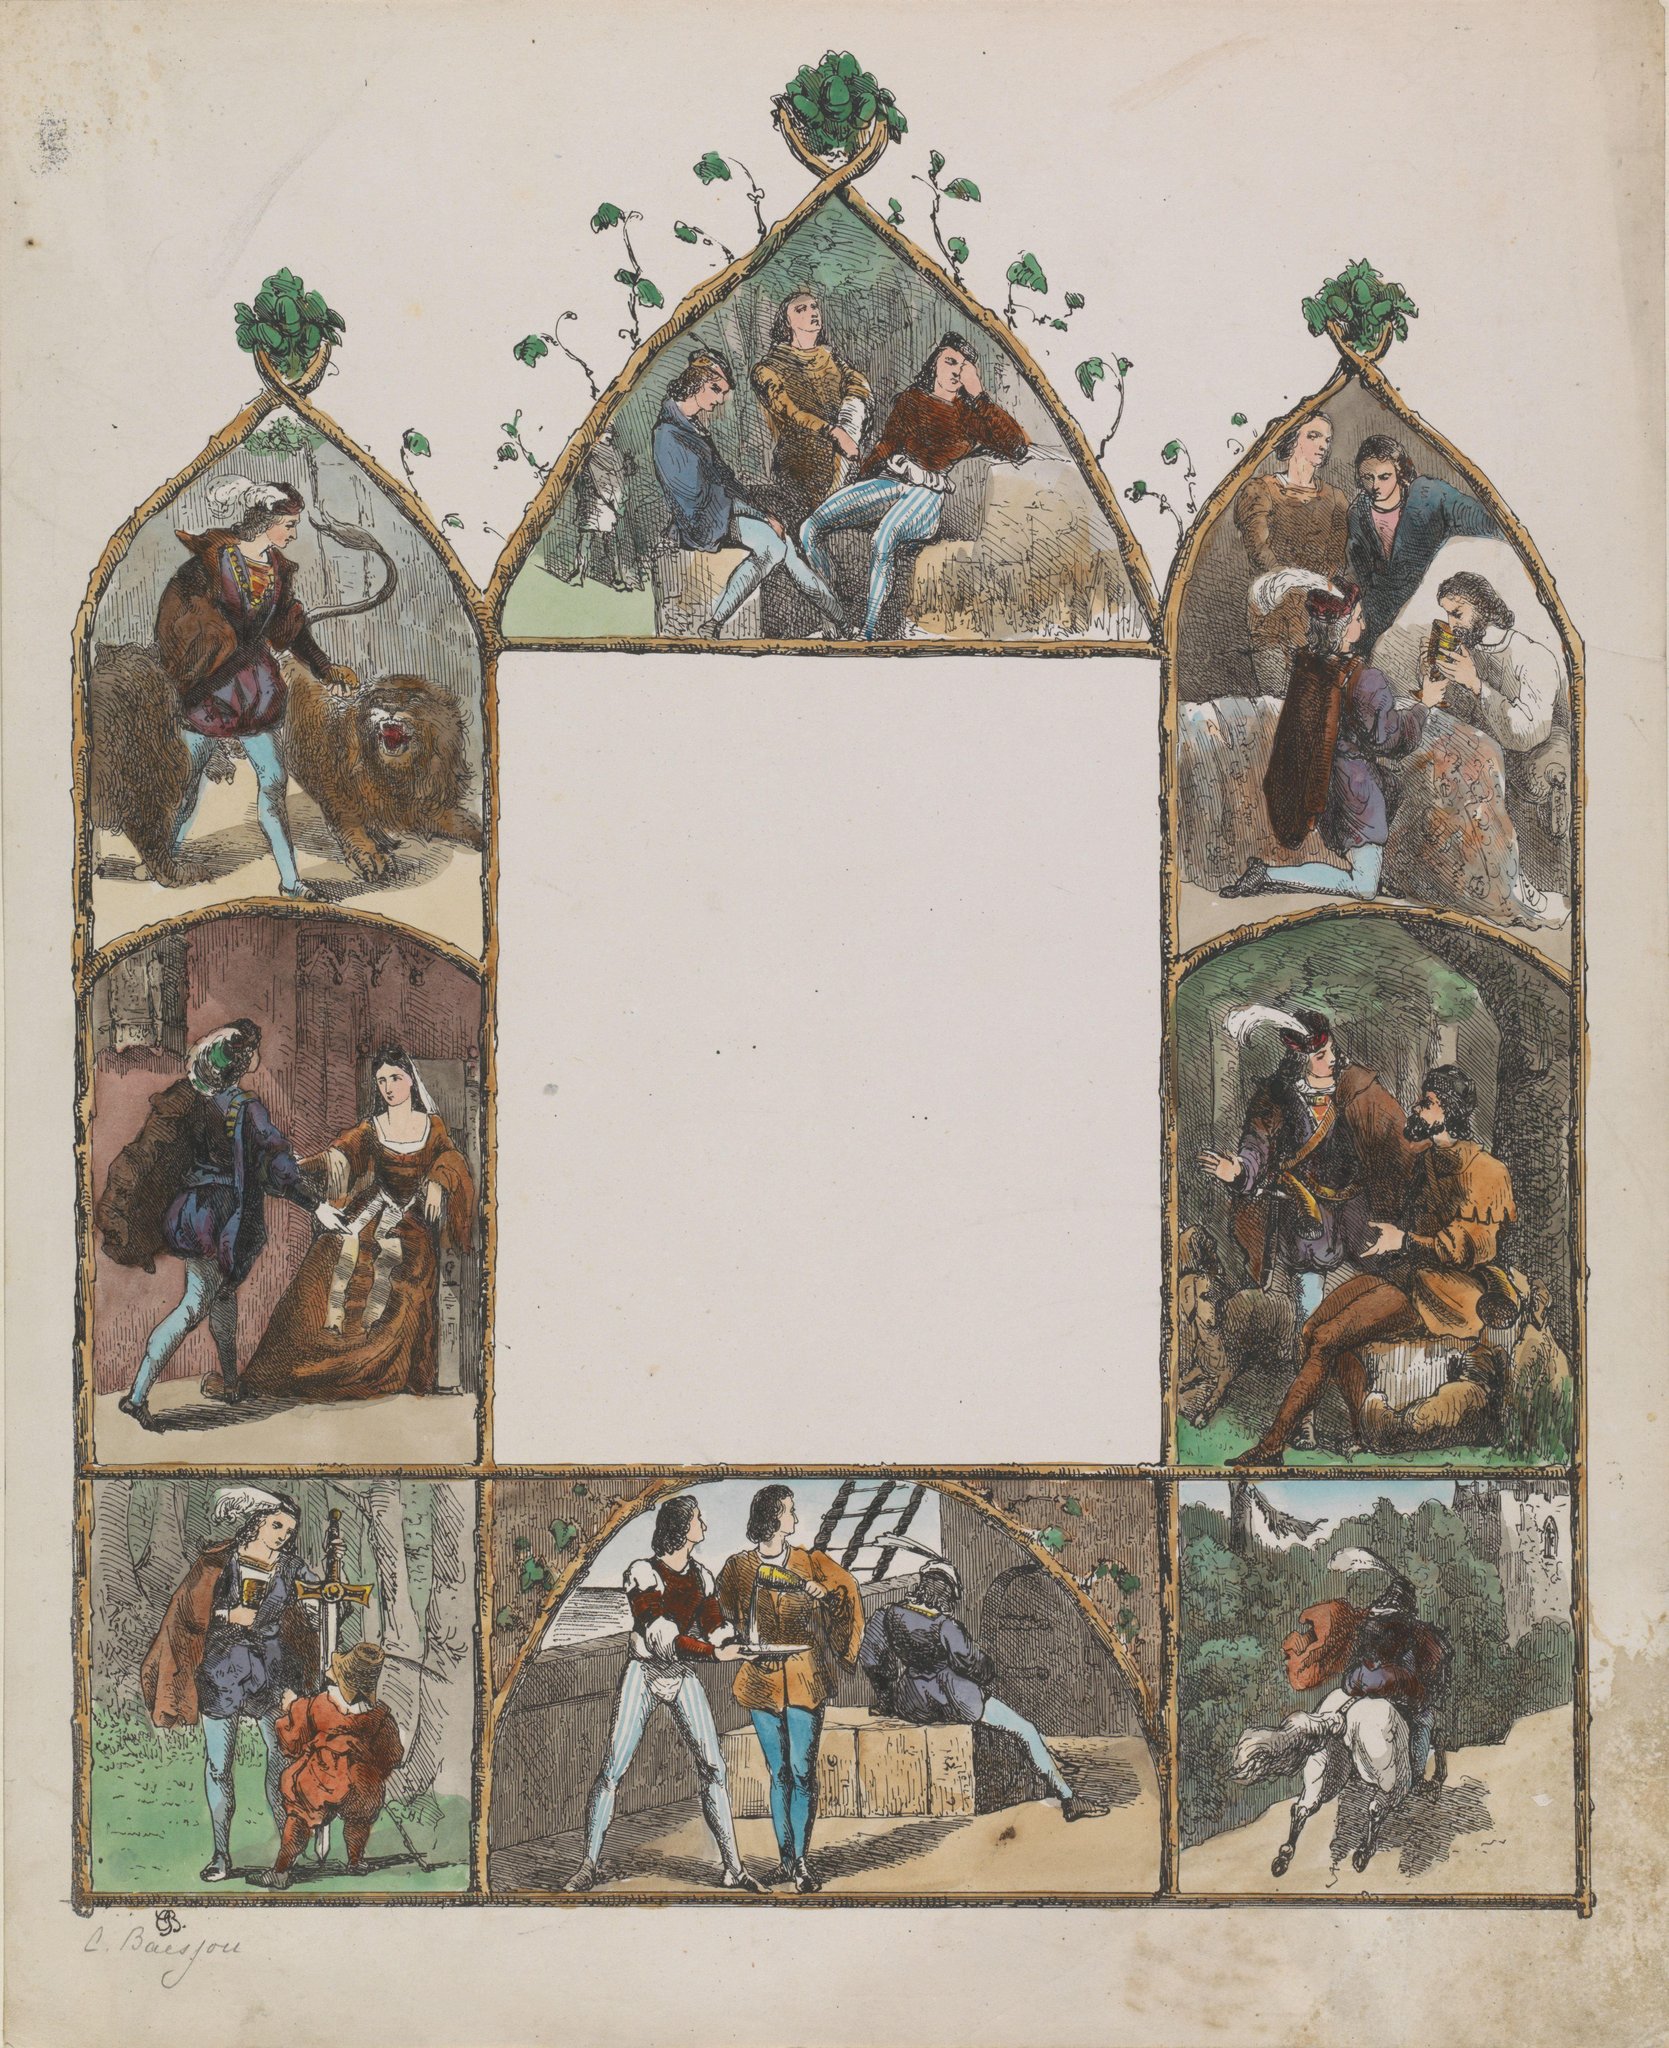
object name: popular print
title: Wensbrief met een verhaal over een prins en een prinses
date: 1851-1914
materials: paper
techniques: colour, lithograph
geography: netherlands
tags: prince, princess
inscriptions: collector's mark: Lugt 2760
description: Wensbrief met onbeschreven cartouche binnen een decoratief kader met voorstellingen uit een verhaal over een prins en een prinses.